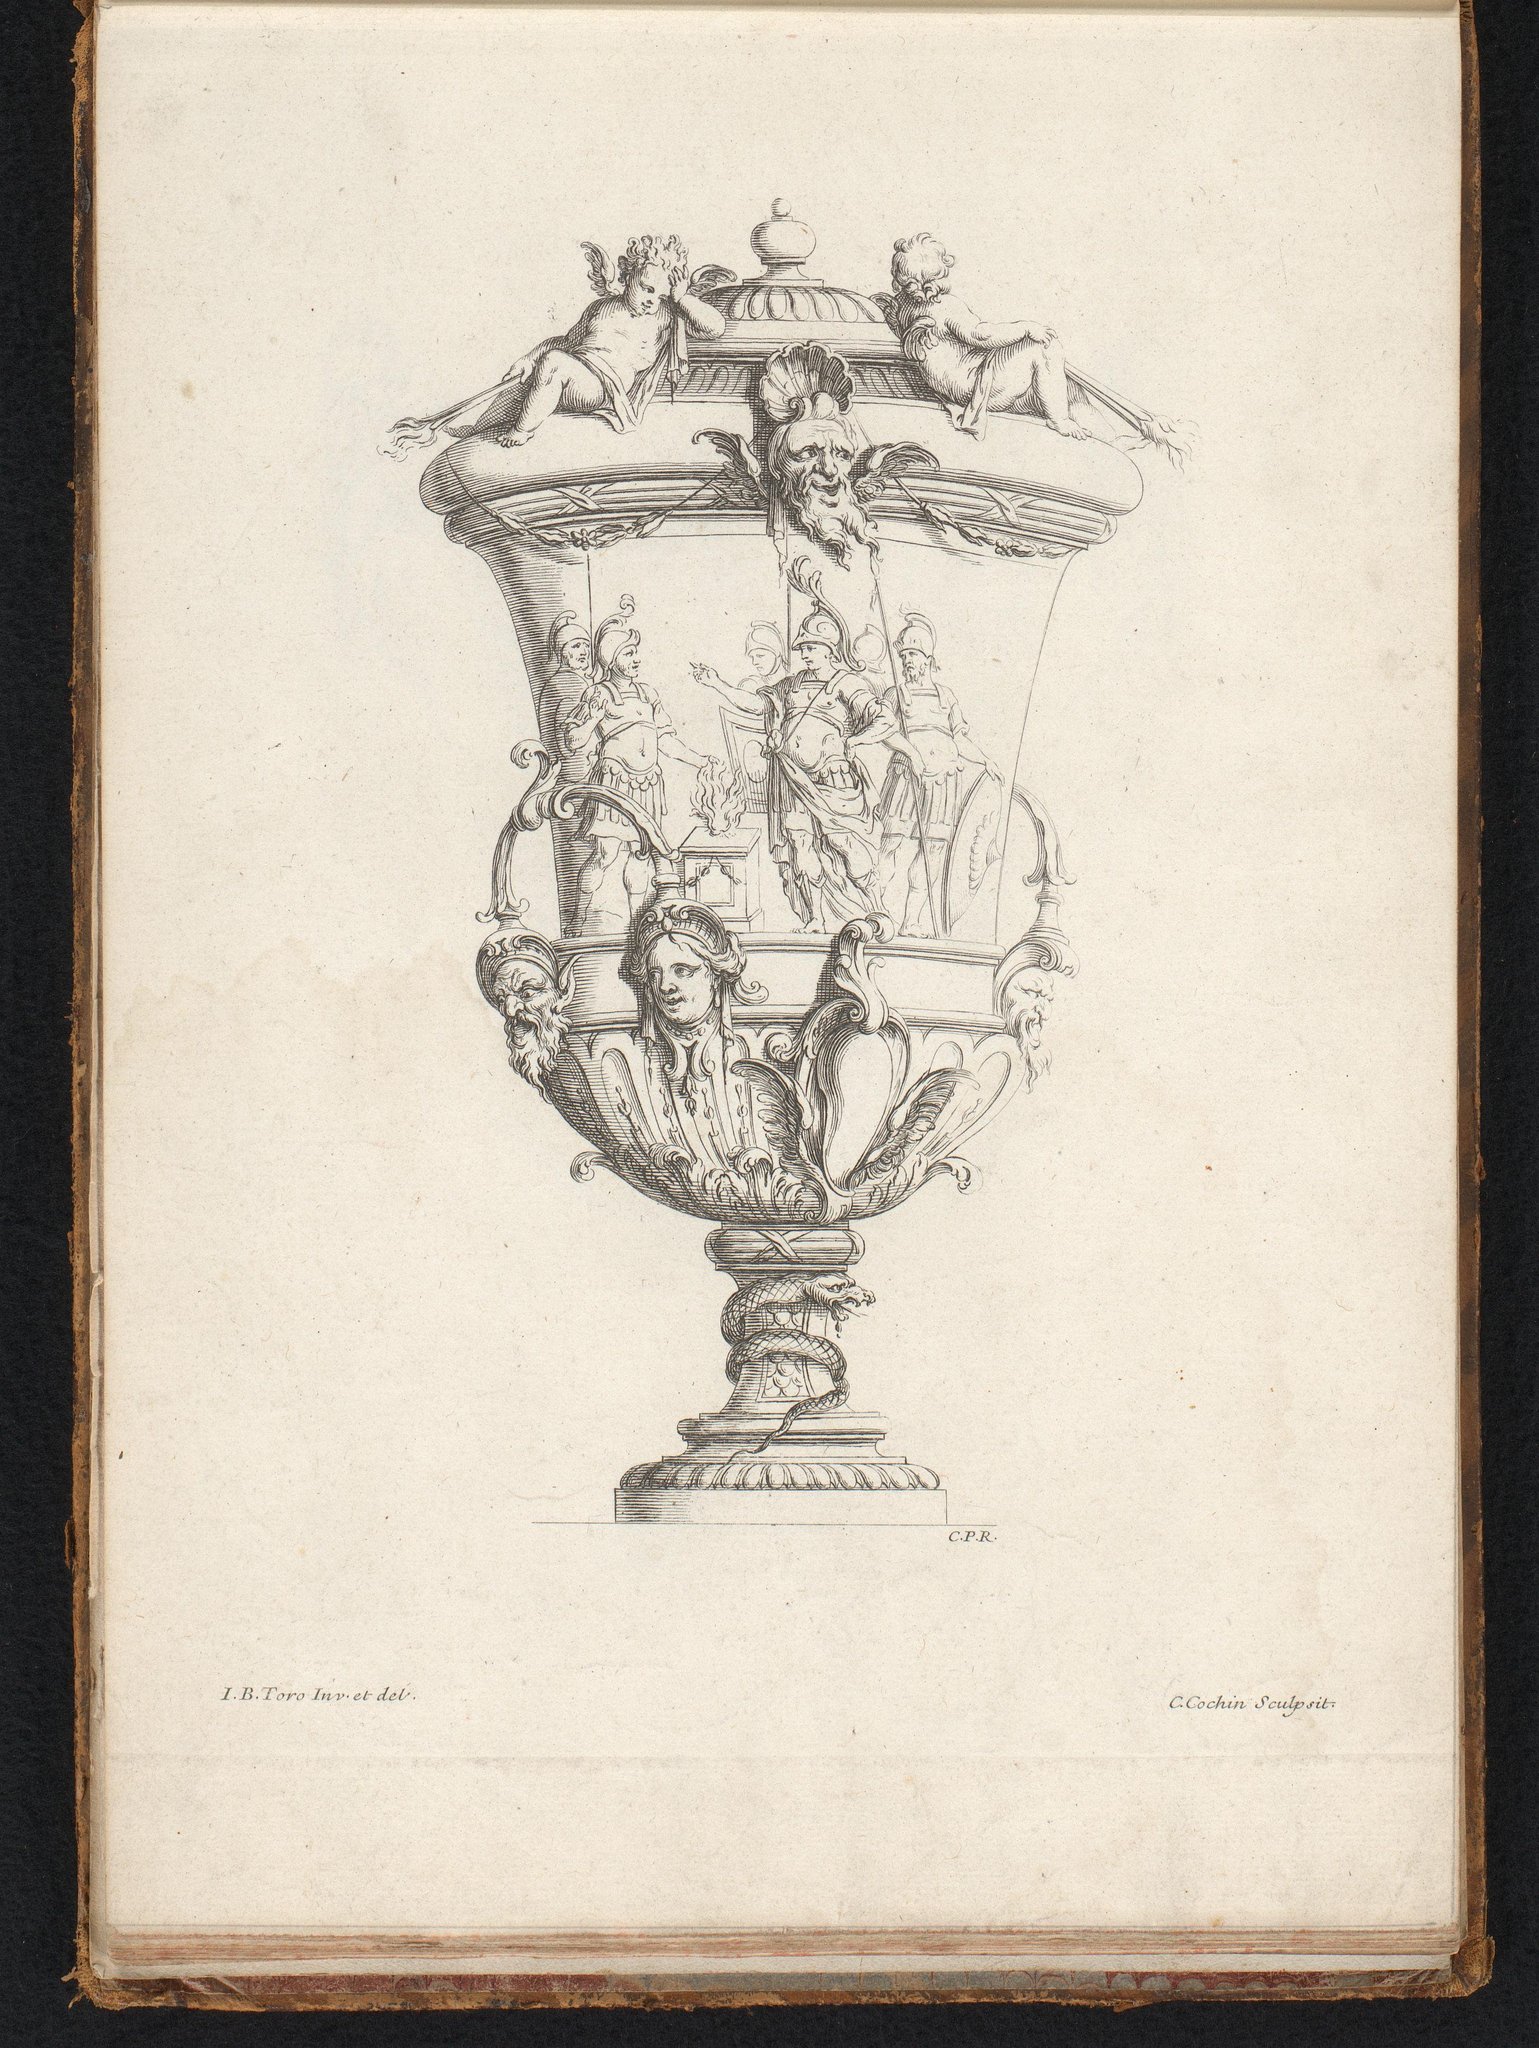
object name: album leaf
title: Vaas met soldaten bij een vuur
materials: paper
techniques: engraving, etching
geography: paris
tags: vase ~ ornament, the soldier; the soldier's life, garden vase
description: Prent maakt deel uit van een serie van zeven prenten.